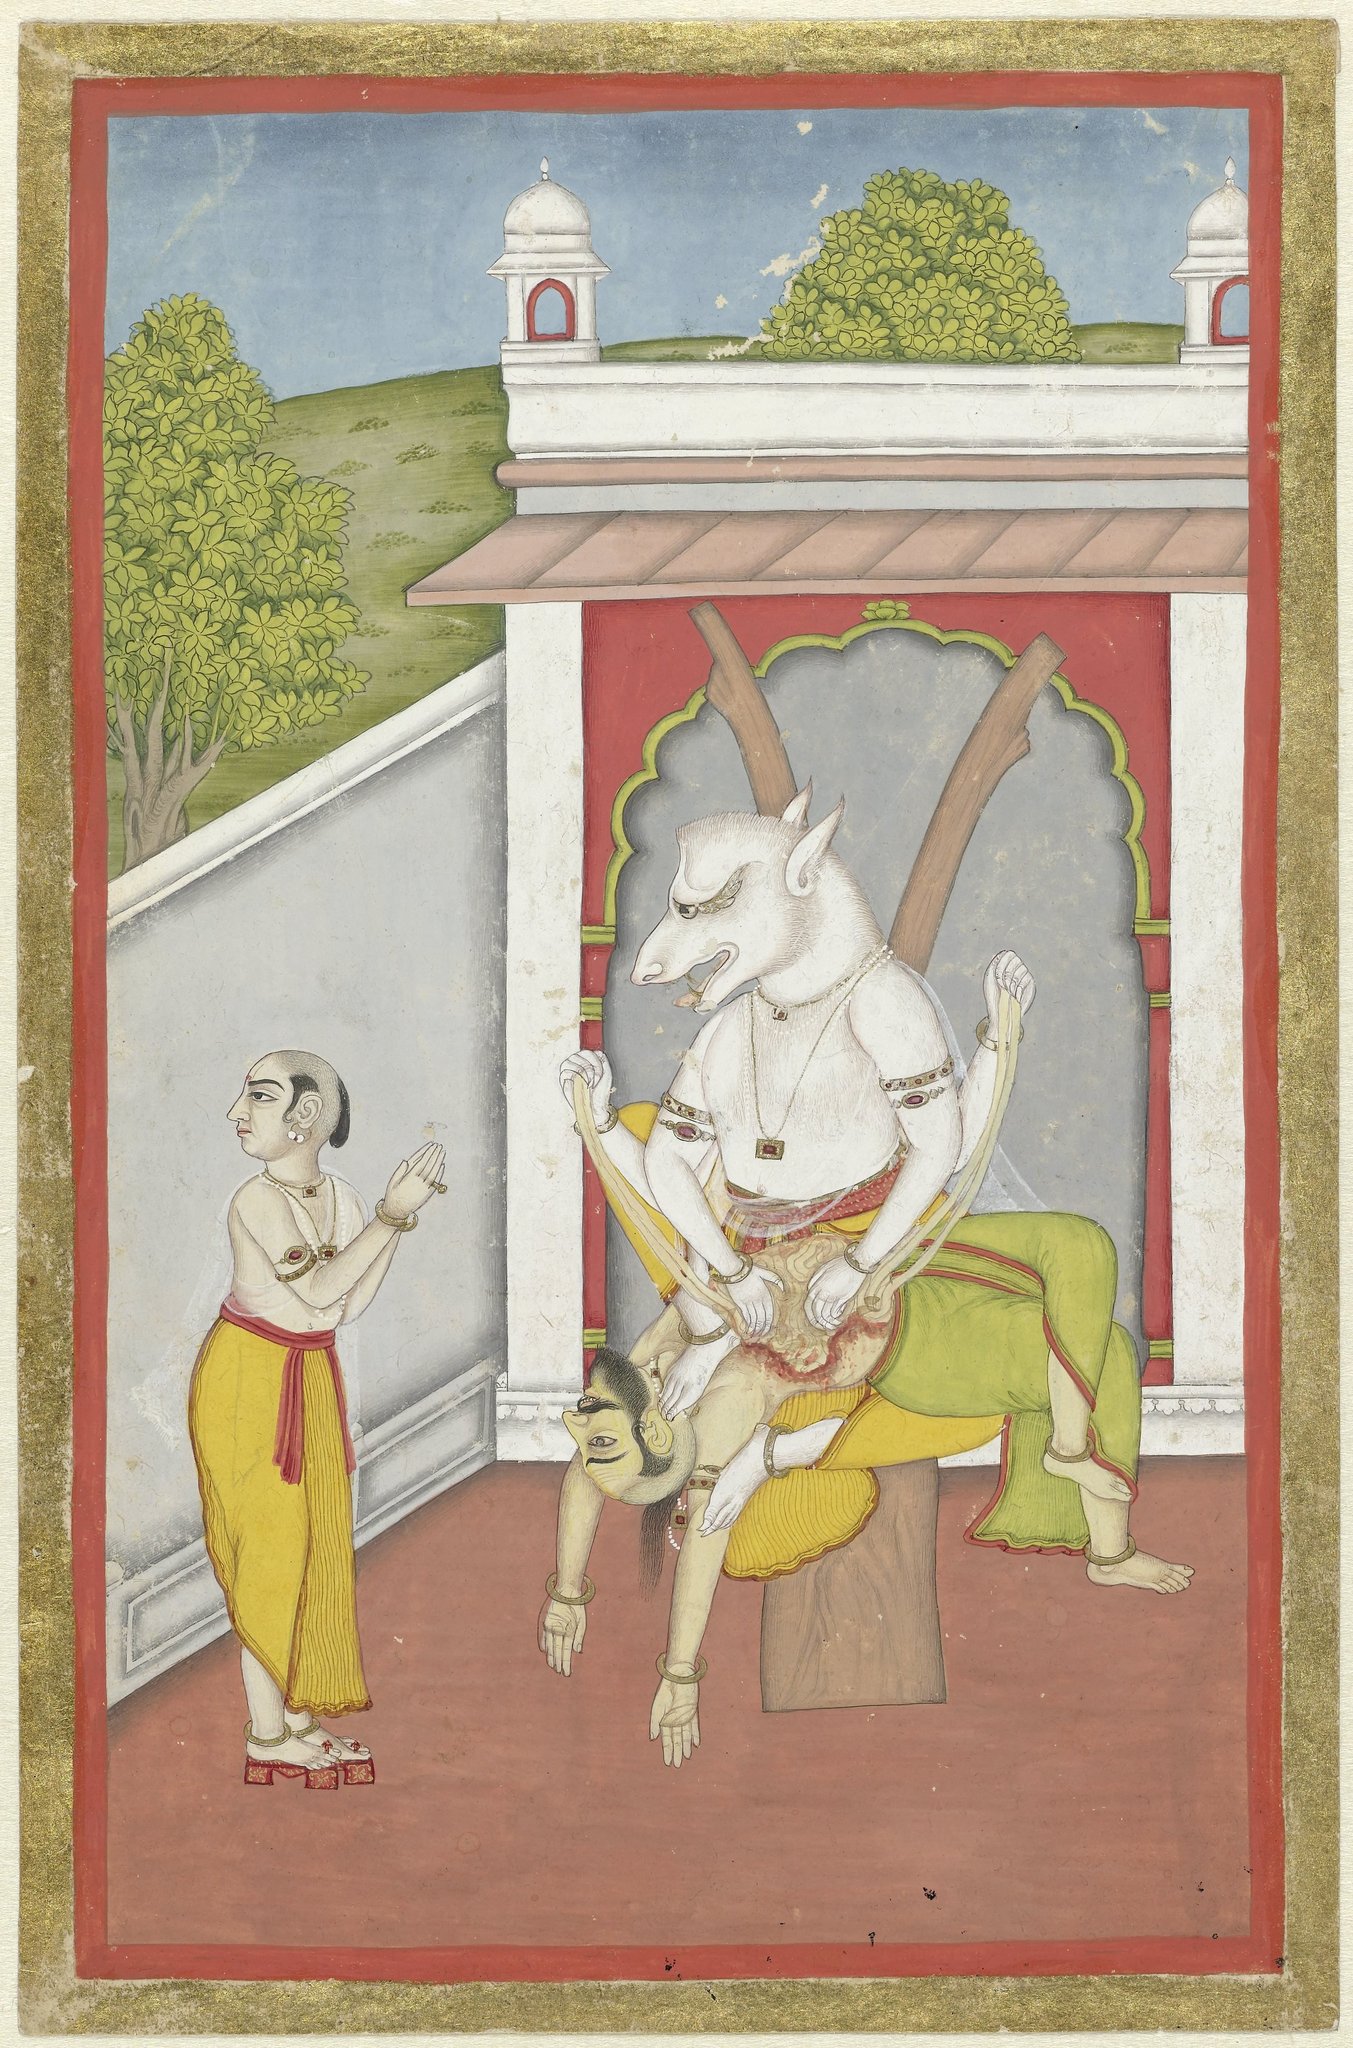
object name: indian miniature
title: Narasimha (de man-leeuw incarnatie van Vishnu)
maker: Anonymous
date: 1790-1810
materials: paper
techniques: brush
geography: murshidabad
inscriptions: inscription: ‘.’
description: Voor de ingang van een paleis zit Vishnu in zijn incarnatie (avatara) als man-leeuw met een man over zijn schoot waarvan hij de ingewanden opengelegd heeft; voor hem een eerbiedige man (de prins Prahlada) met gevouwen handen. Rondom de voorstelling een smalle oranje en een smalle gouden rand.